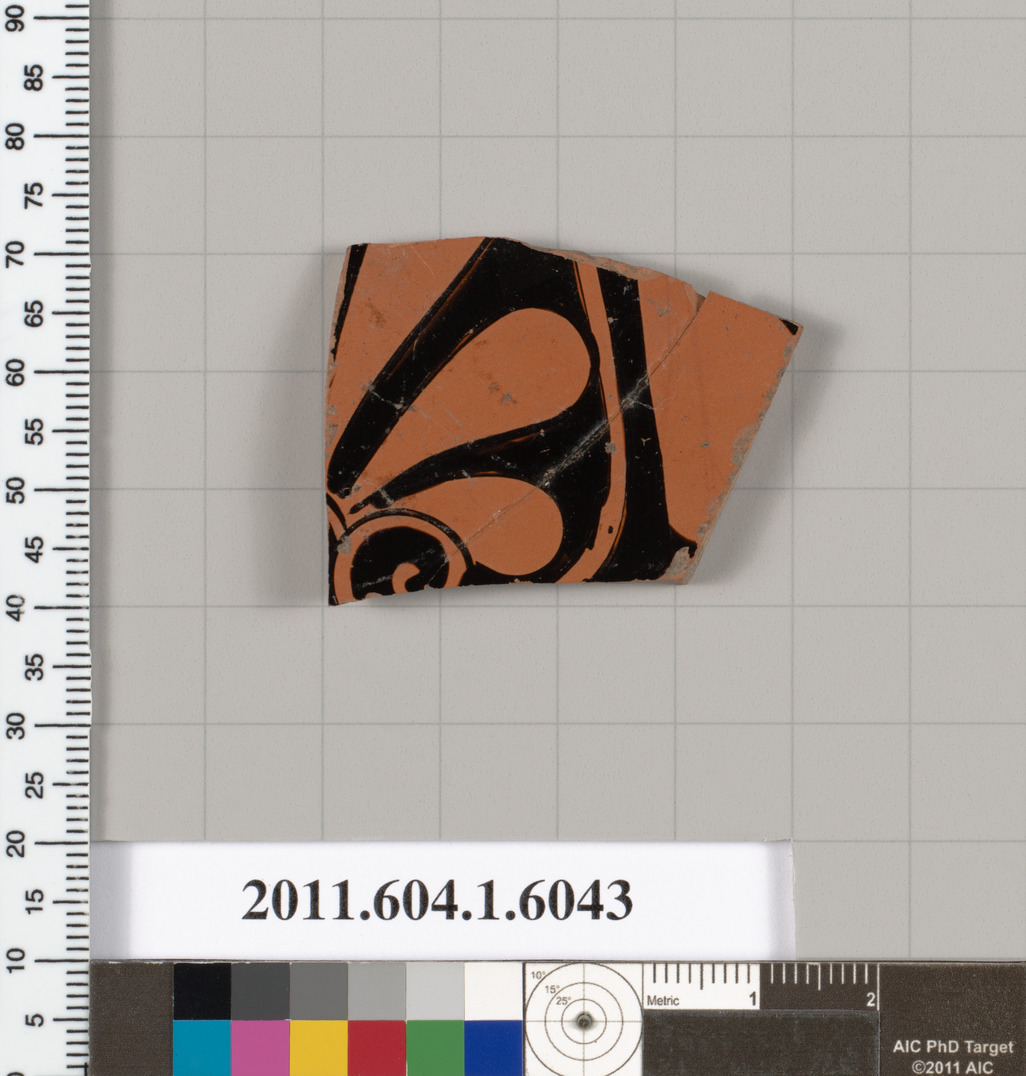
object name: kylix fragment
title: Terracotta fragment of a kylix (drinking cup)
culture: greek, attic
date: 510-500 BCE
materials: terracotta